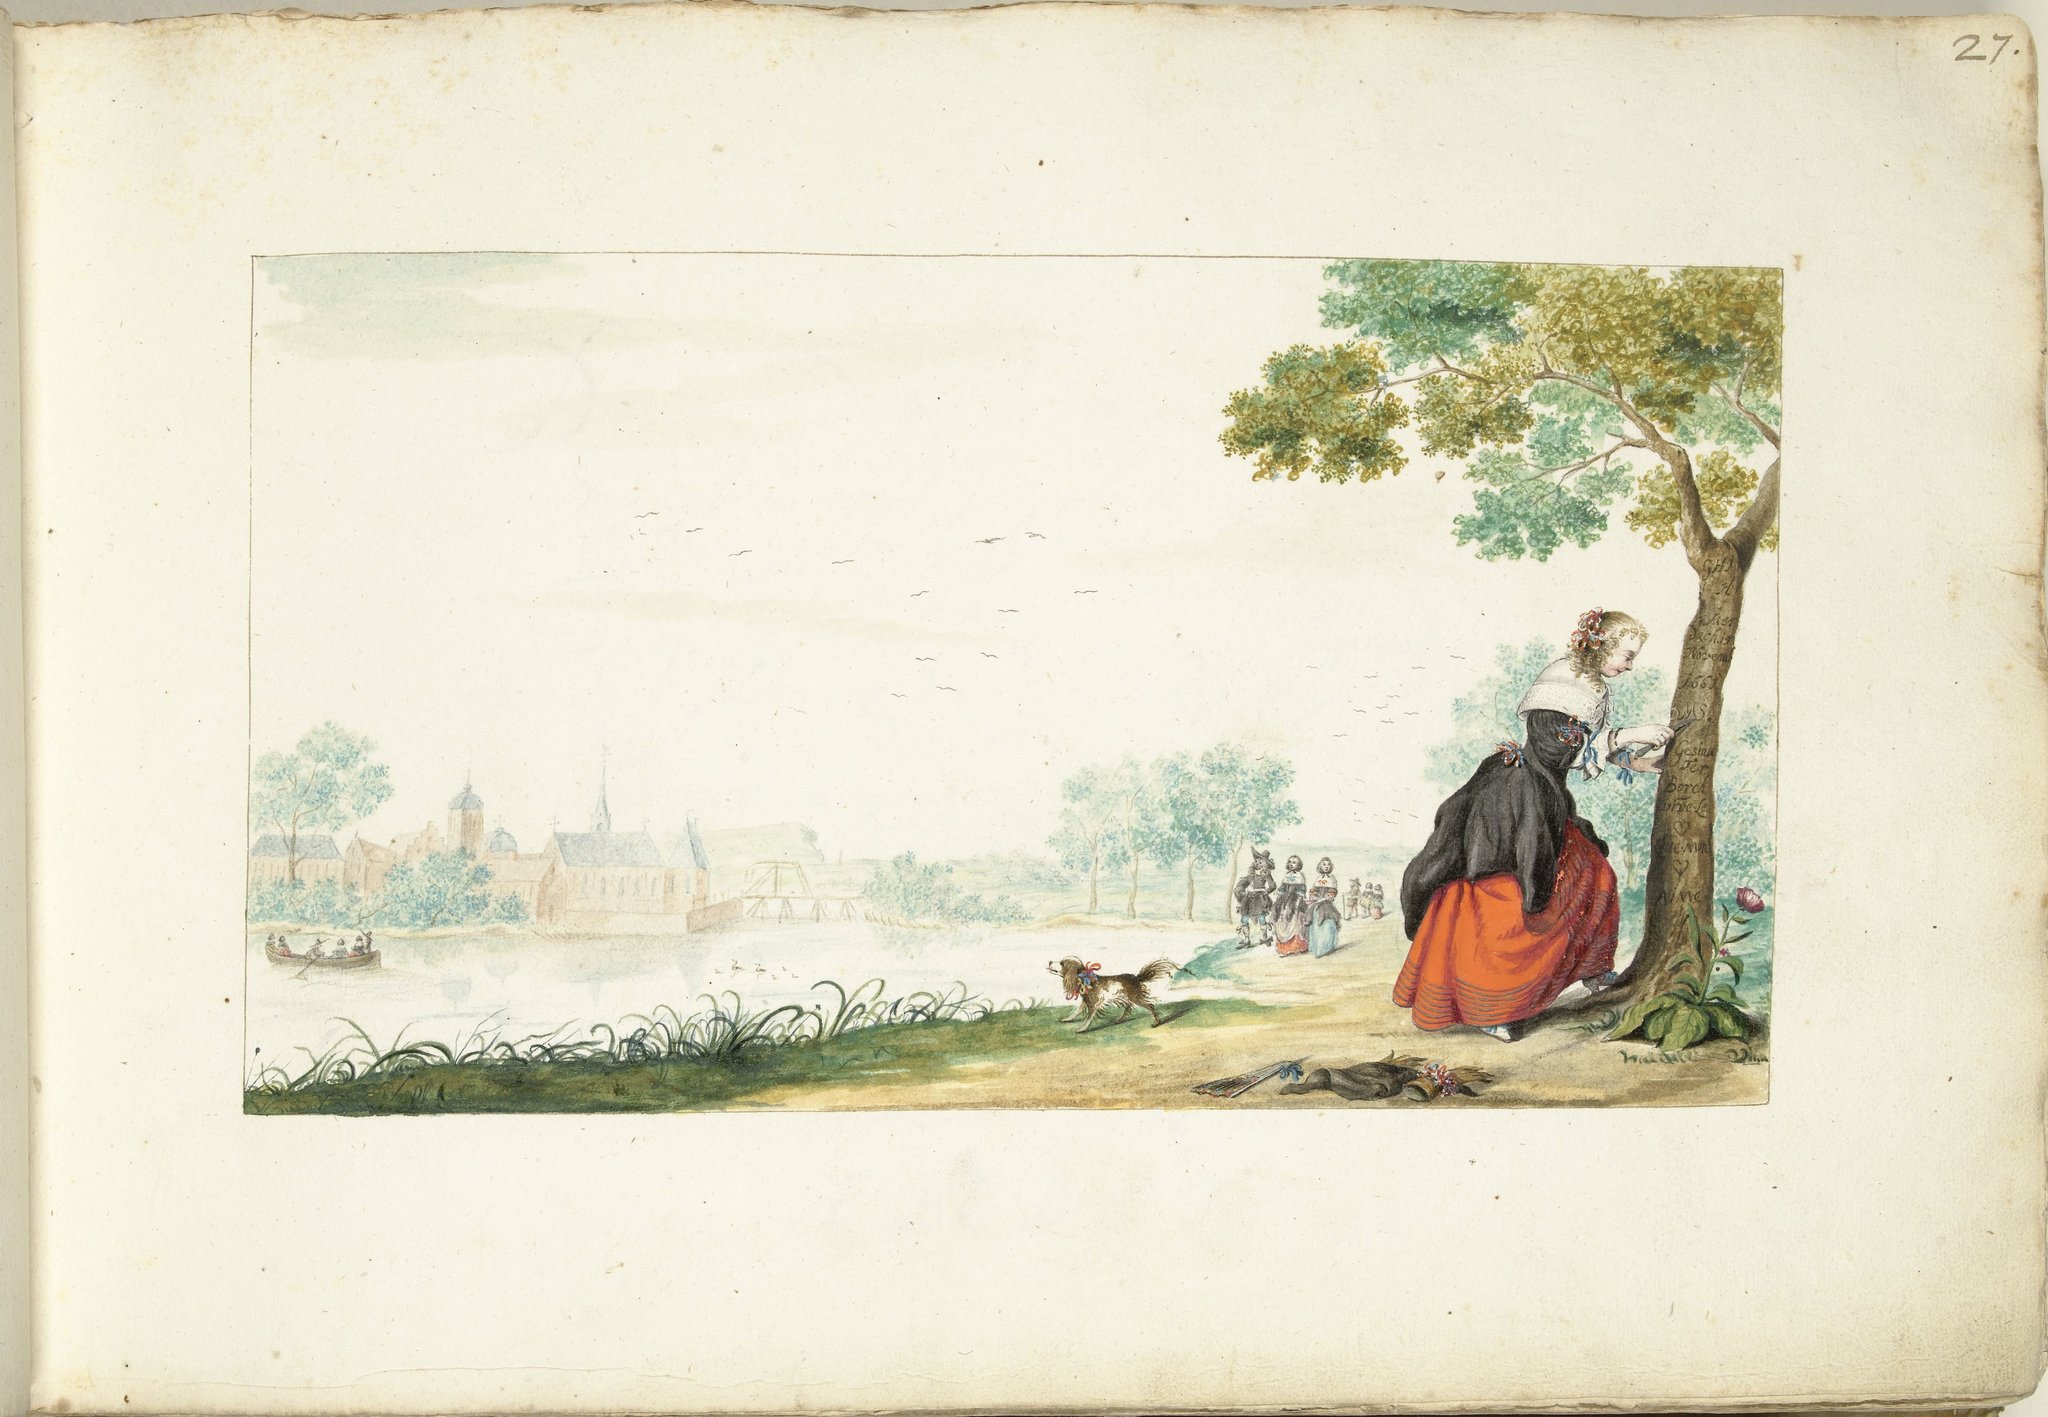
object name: drawing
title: Vrouw die namen in een boom grift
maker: gesina ter borch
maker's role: draughtsman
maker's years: 1633-1690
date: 1661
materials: paint, ink, paper, watercolor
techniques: brush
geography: zwolle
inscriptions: signature, date and inscription: ‘GHI/H[I?]/ jaer/dach/15/ Novemb/1661/DMS/Gesina/Ter/Borch/vive/le/[hart]/que/mon/[hart]/aime’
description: Waarschijnlijk Gesina zelf die haar motto "Deugd Maakt Schoonheid" in de boom krast, met een verwijzing naar haar hartedief, Henrik Jordis.